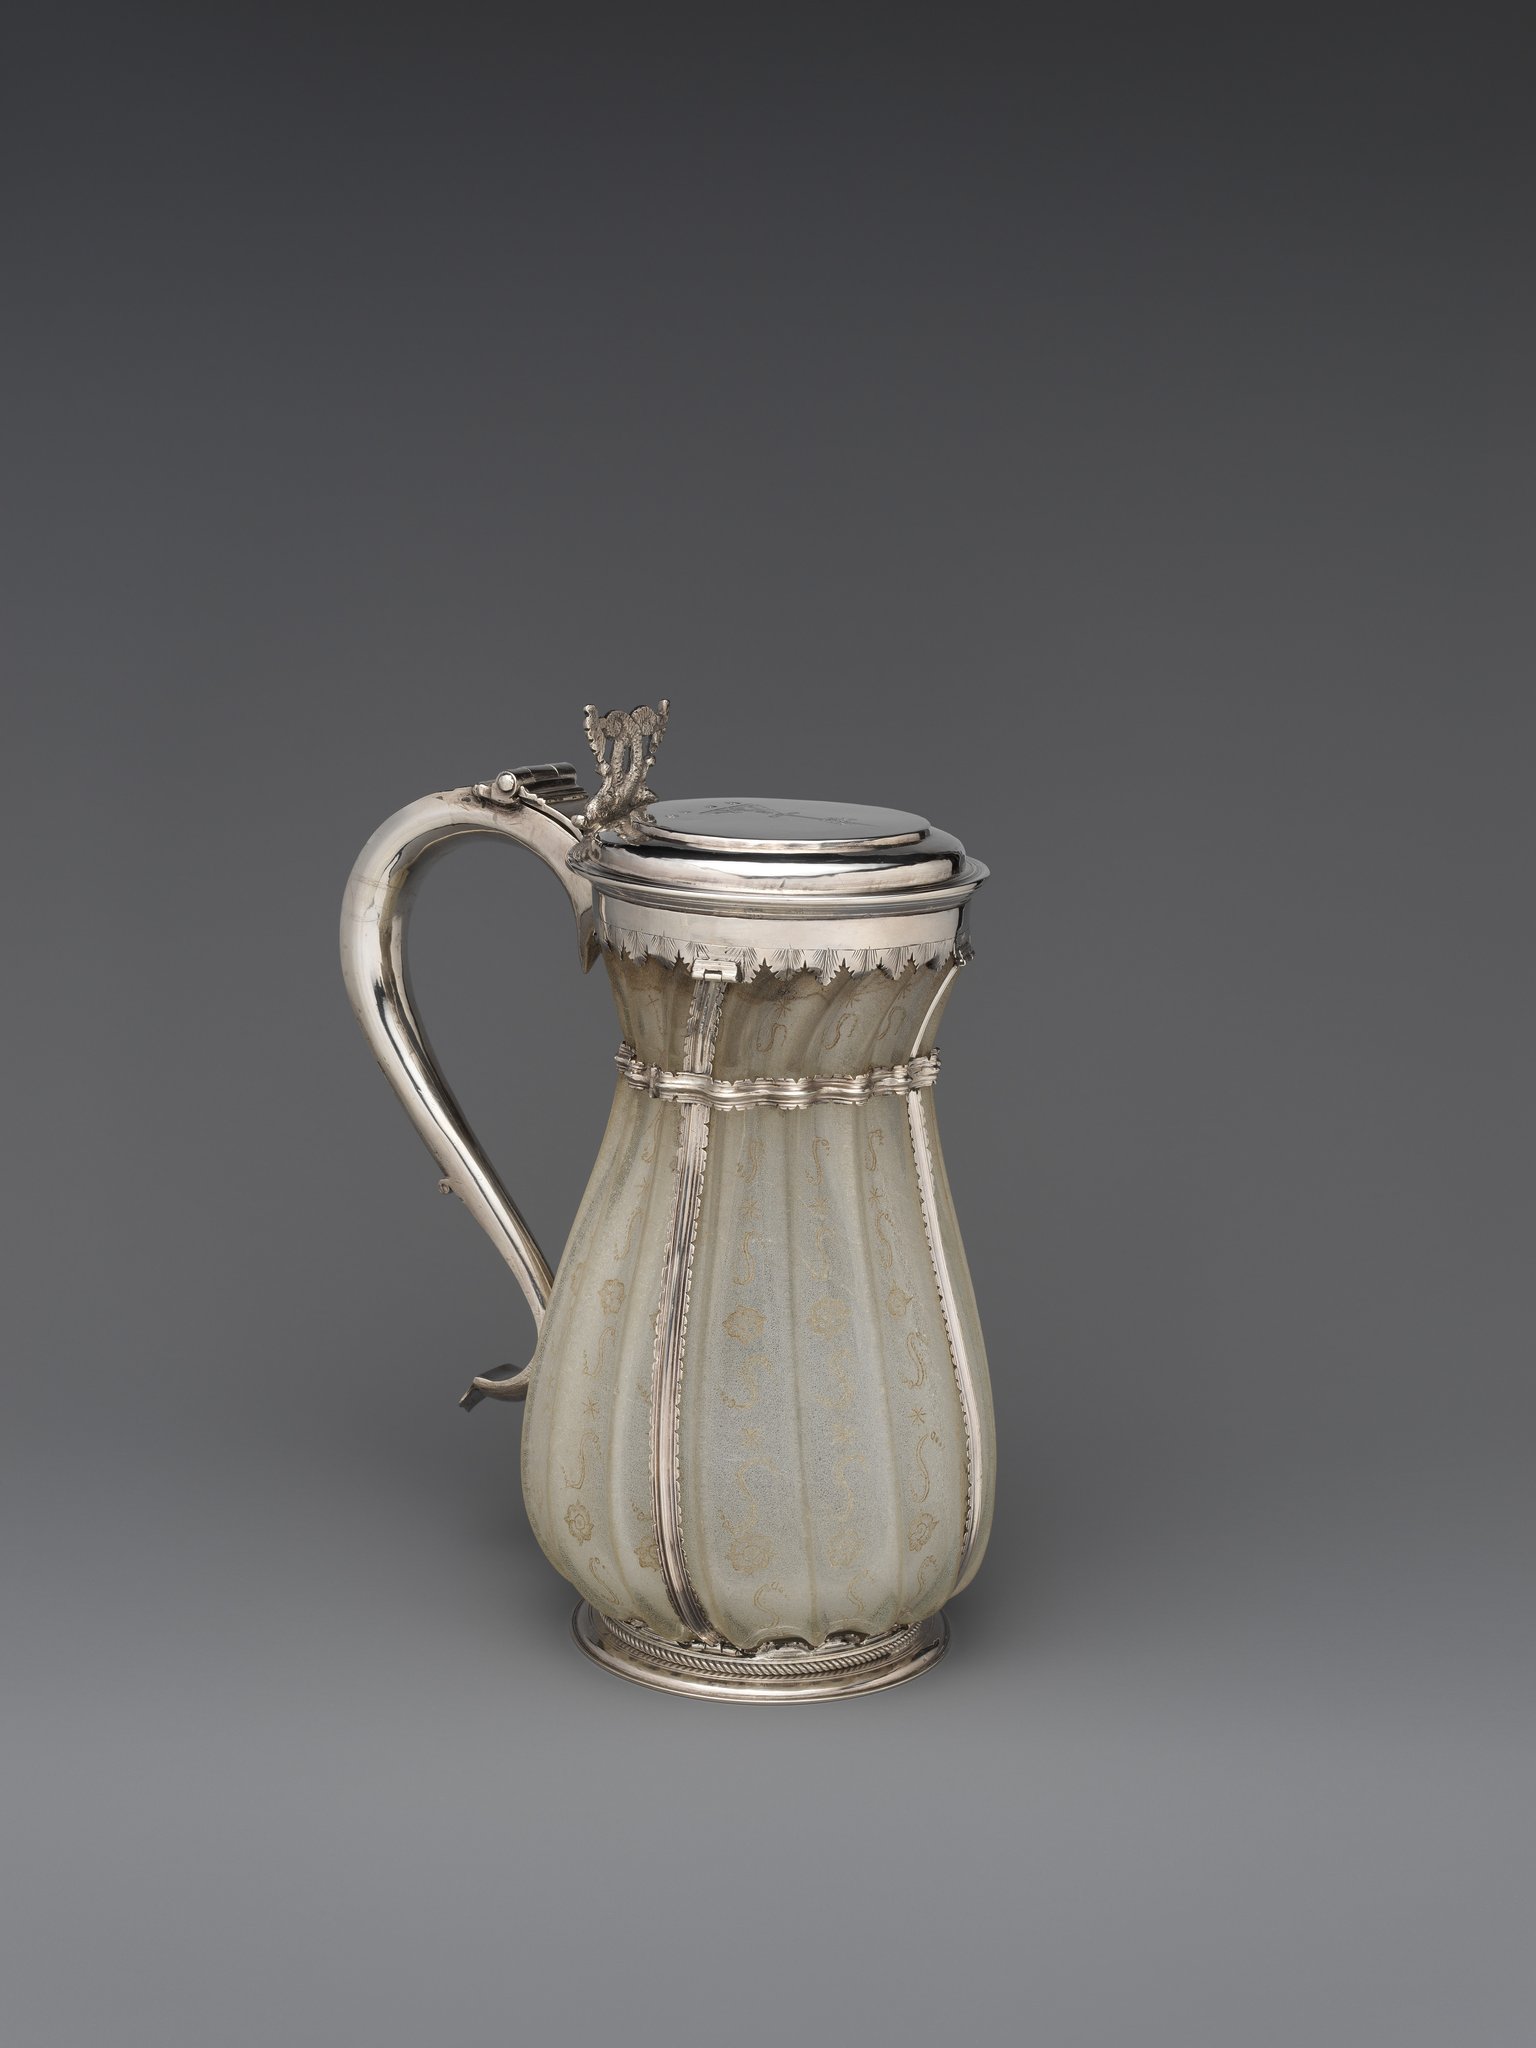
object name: tankard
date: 1675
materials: glass, silver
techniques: engraving